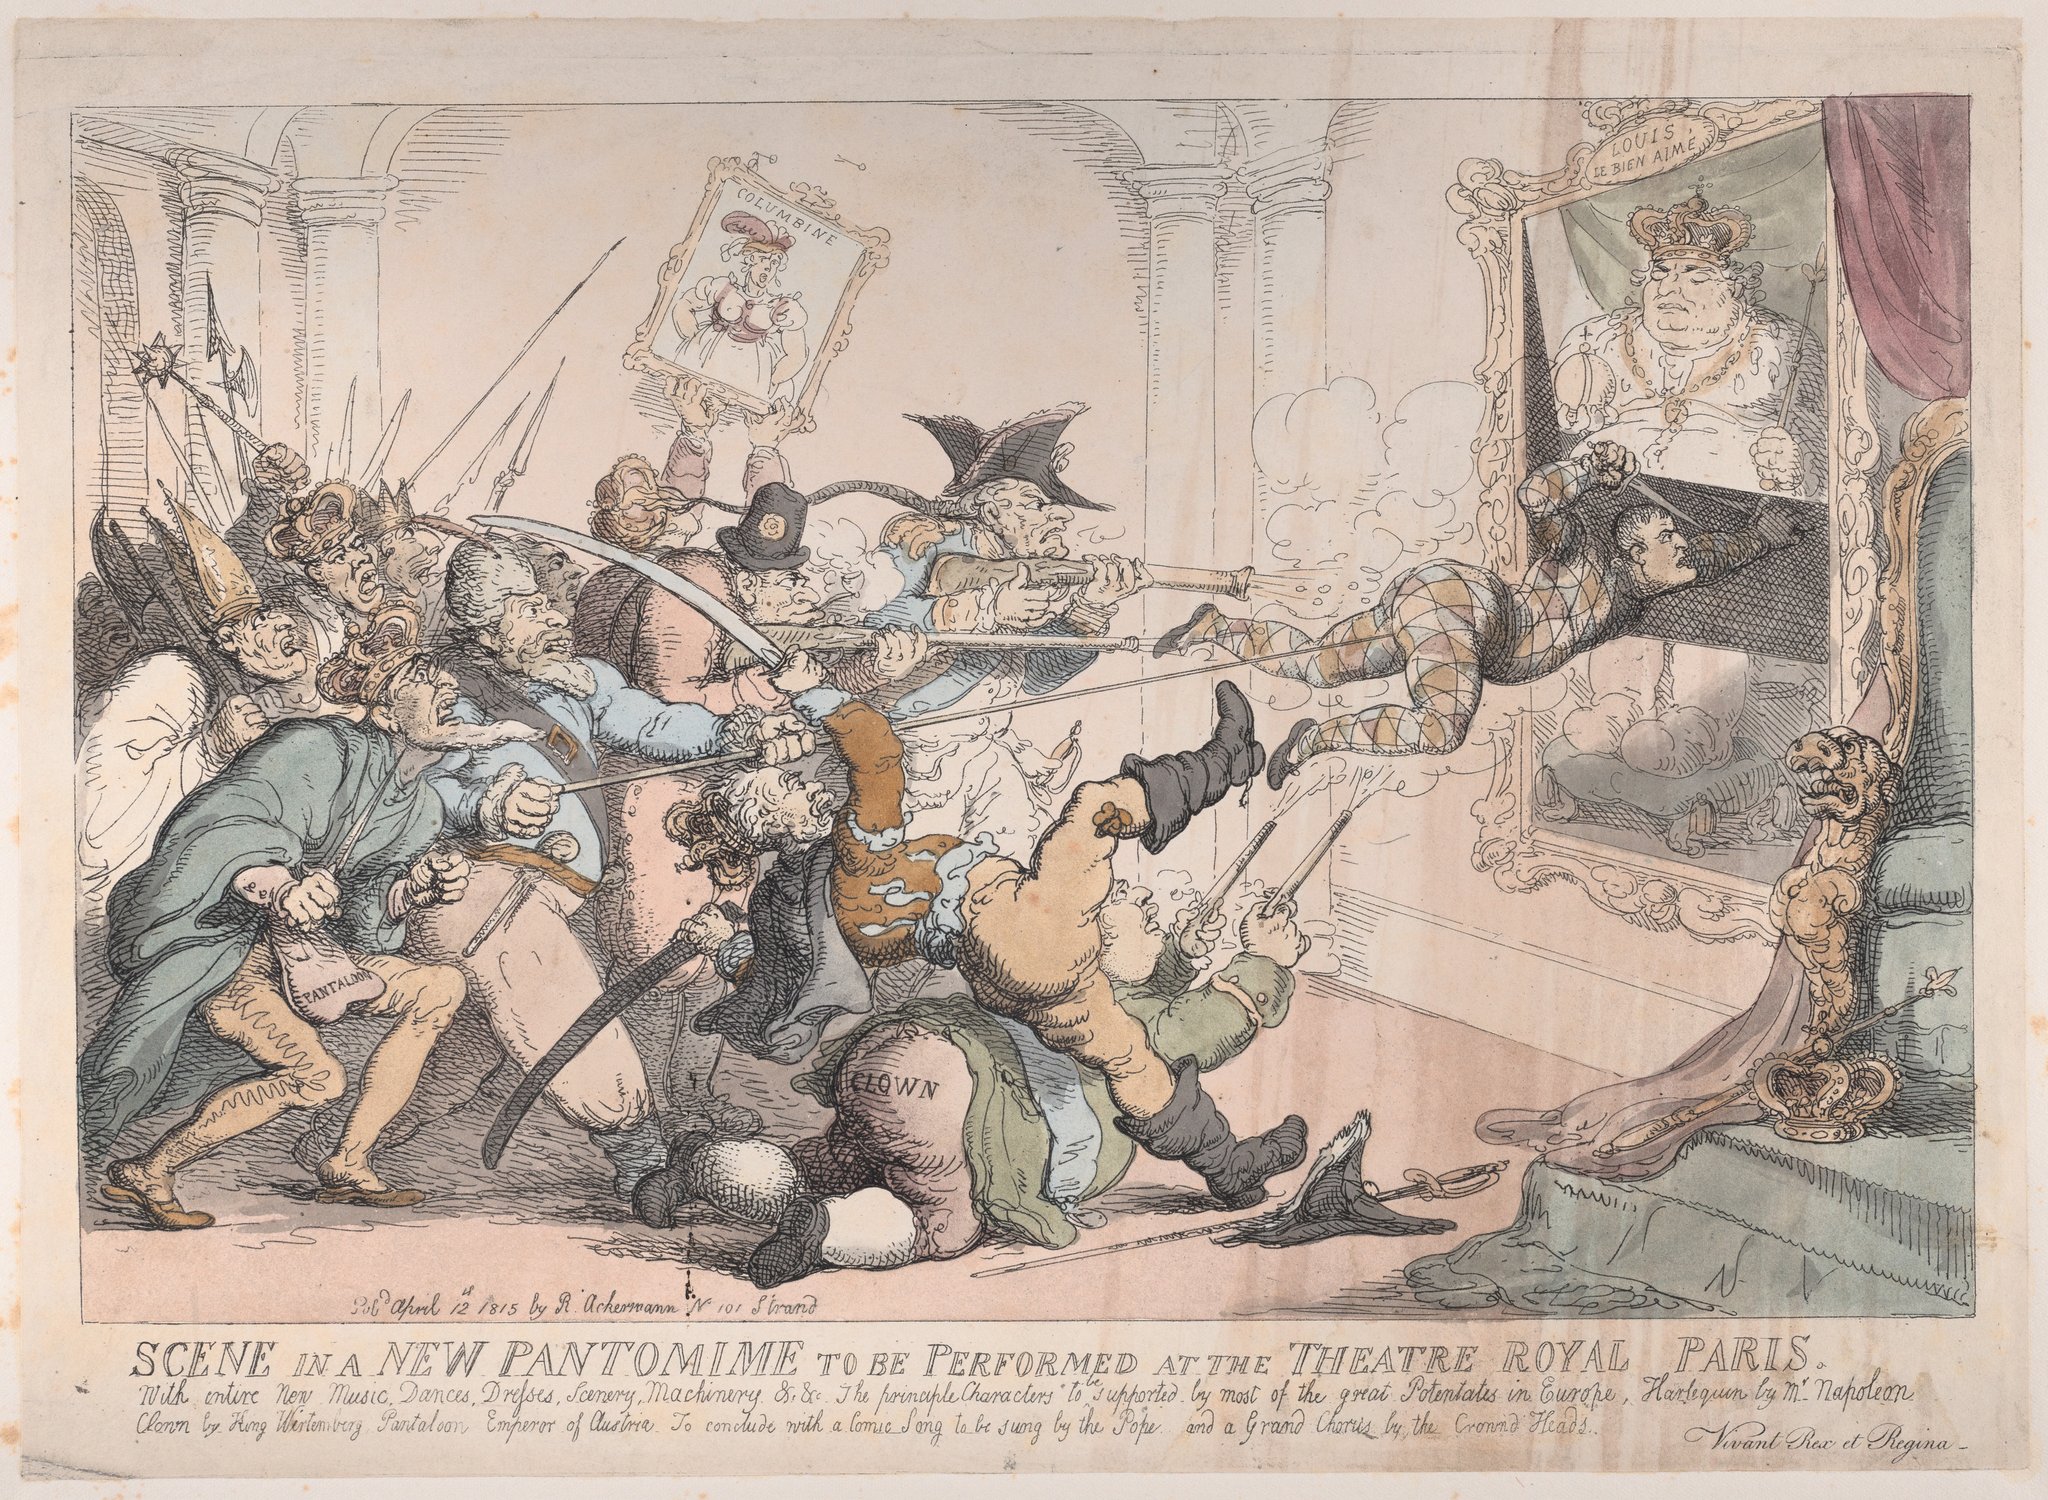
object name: print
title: Scene in a New Pantomime to be Performed at the Theatre Royal Paris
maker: thomas rowlandson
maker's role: artist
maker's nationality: british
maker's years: 1757-1827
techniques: etching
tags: satire,napoleon i,men,politics